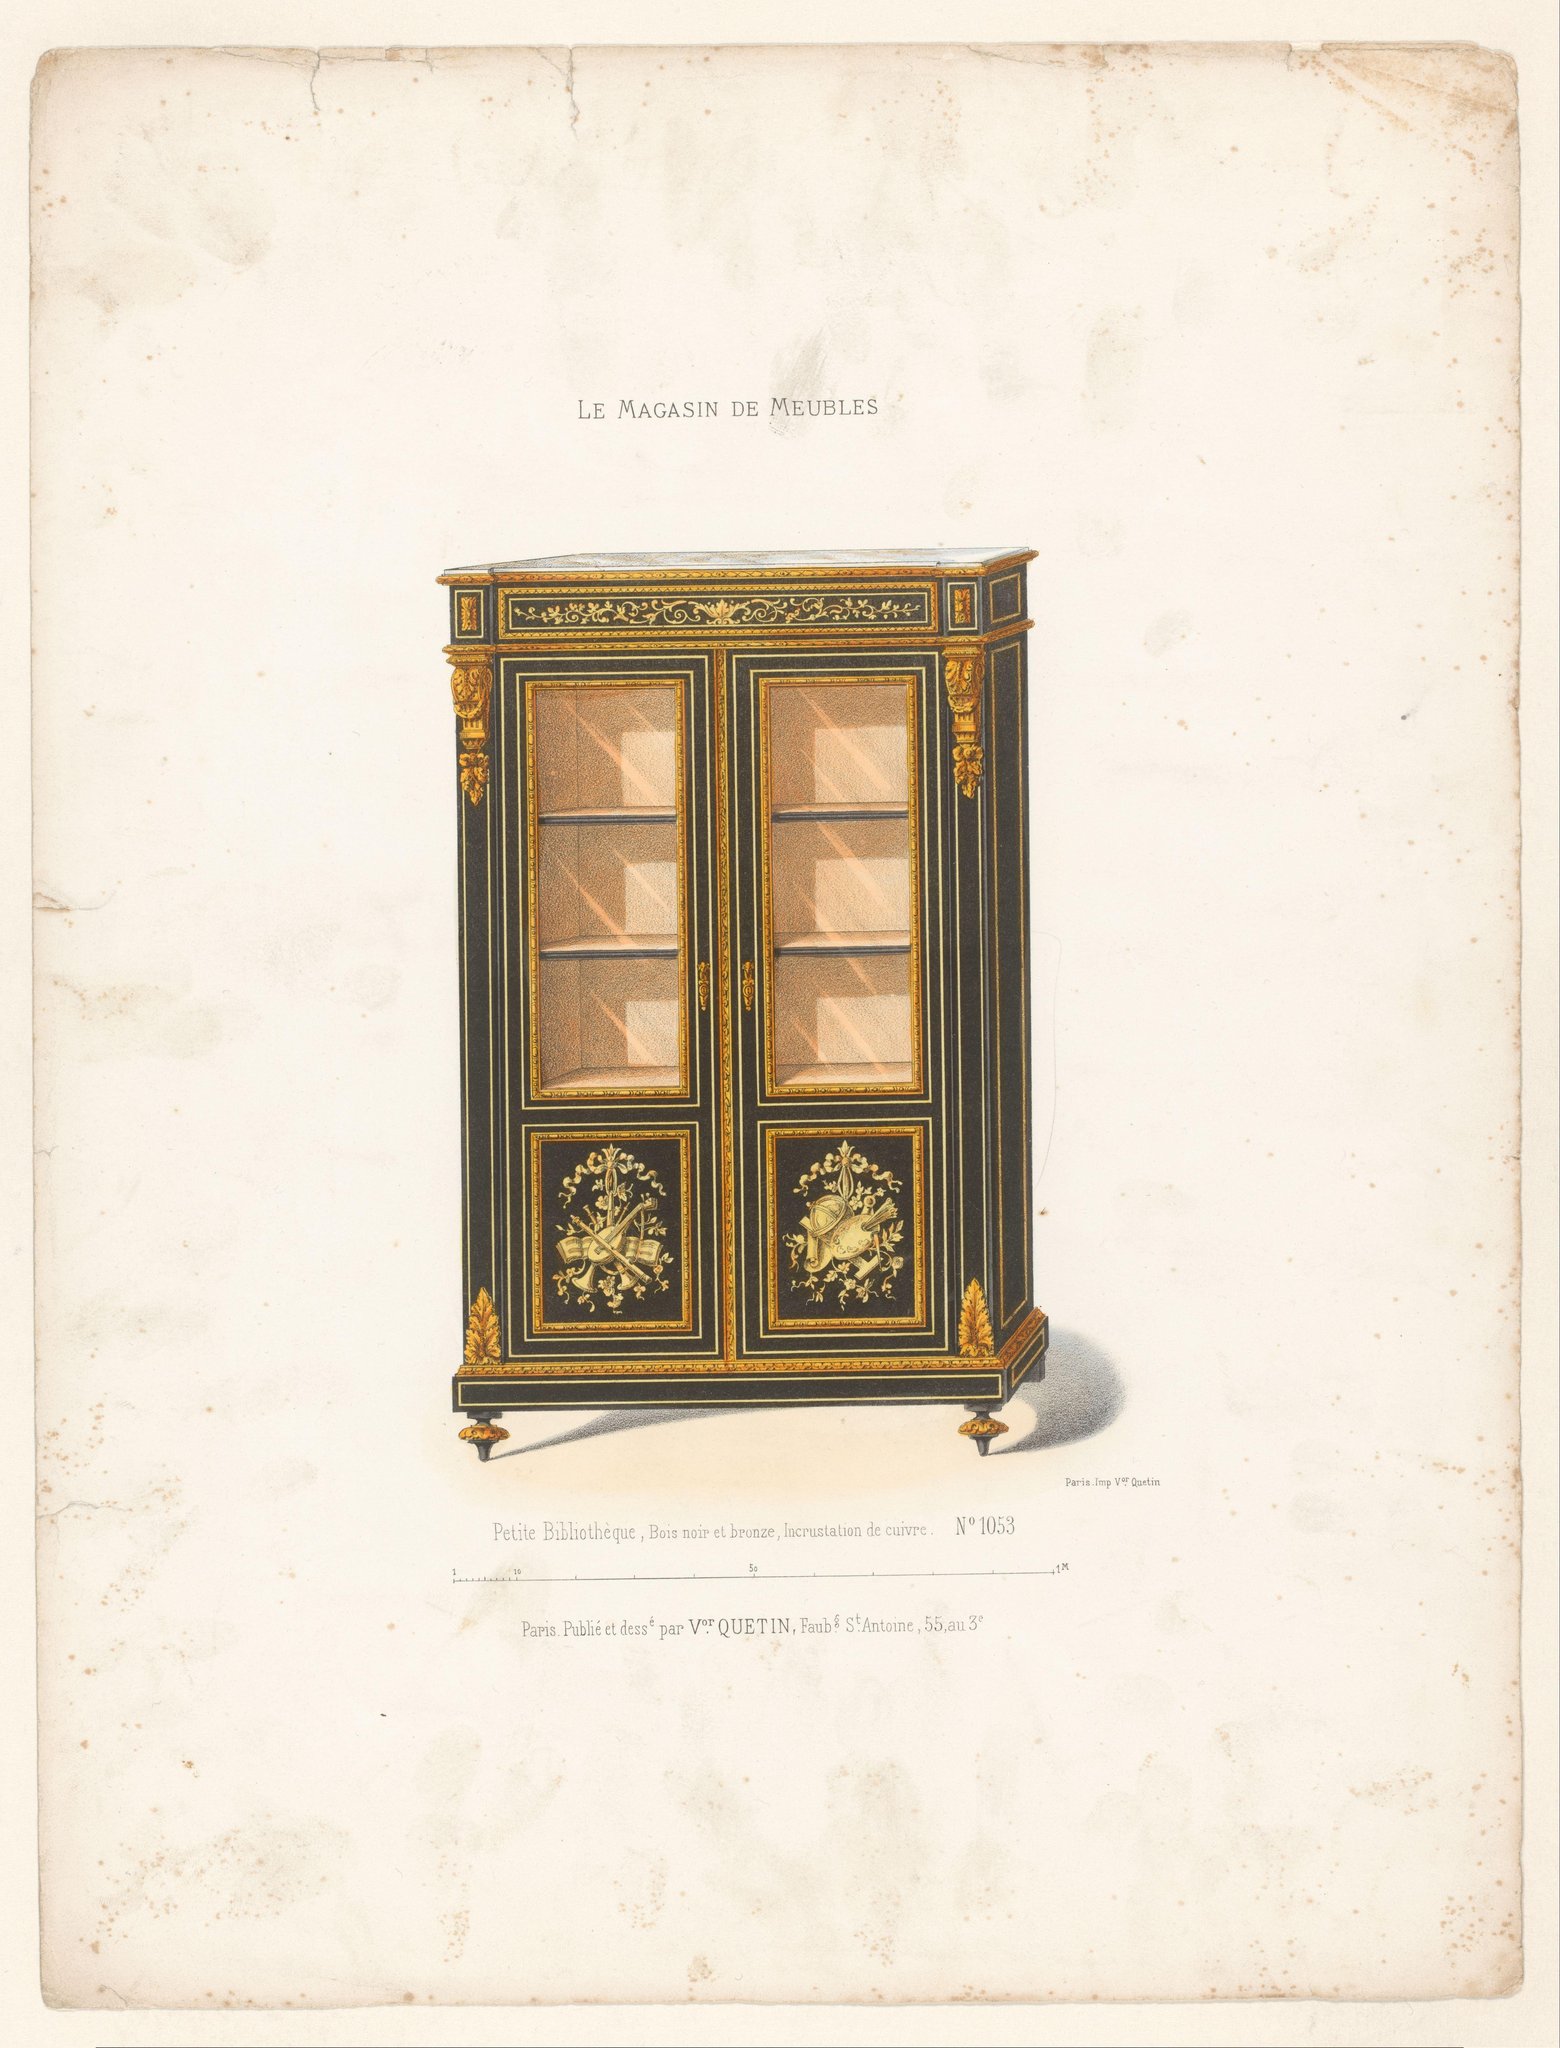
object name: print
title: Boekenkast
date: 1832-1877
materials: paper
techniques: hand coloring, lithograph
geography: paris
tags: bookcase, with doors